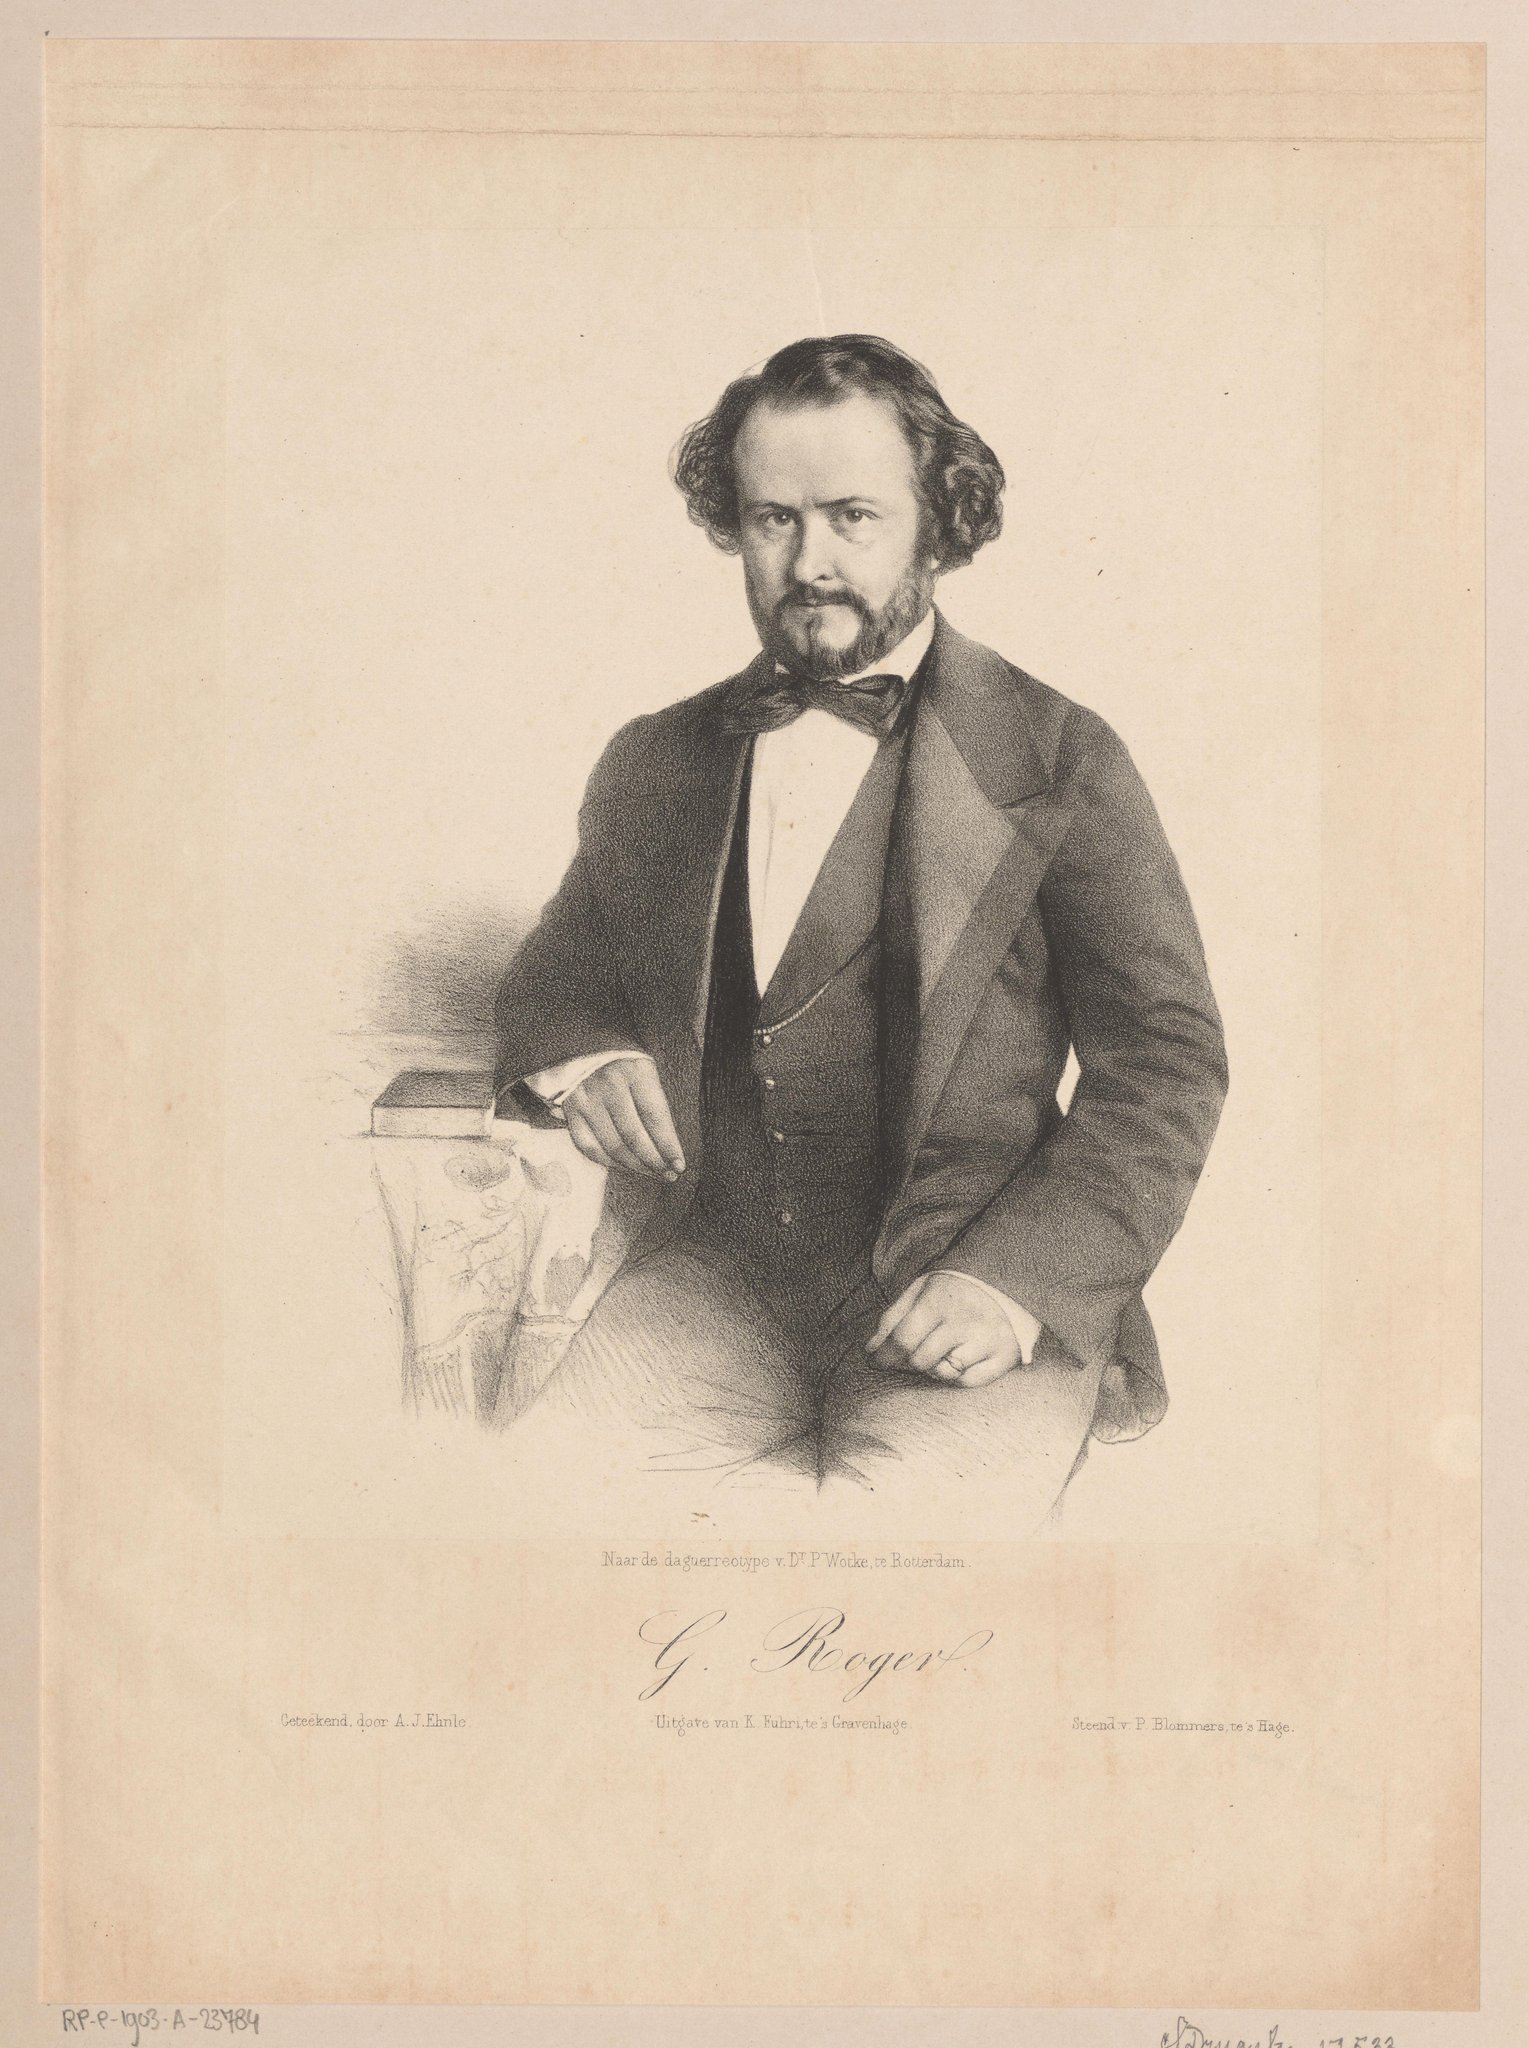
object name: print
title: Portret van Gustave-Hippolyte Roger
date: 1854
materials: paper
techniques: lithograph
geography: the hague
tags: historical persons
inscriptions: collector's mark: Lugt 2228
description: Prent uit een serie van twaalf portretten en twaalf stadsgezichten. Ter gelegenheid van het Muziekfeest ter viering van het 25-jarige bestaan van de Maatschappij ter Bevordering van Toonkunst in Rotterdam, 12-15 juli 1854.